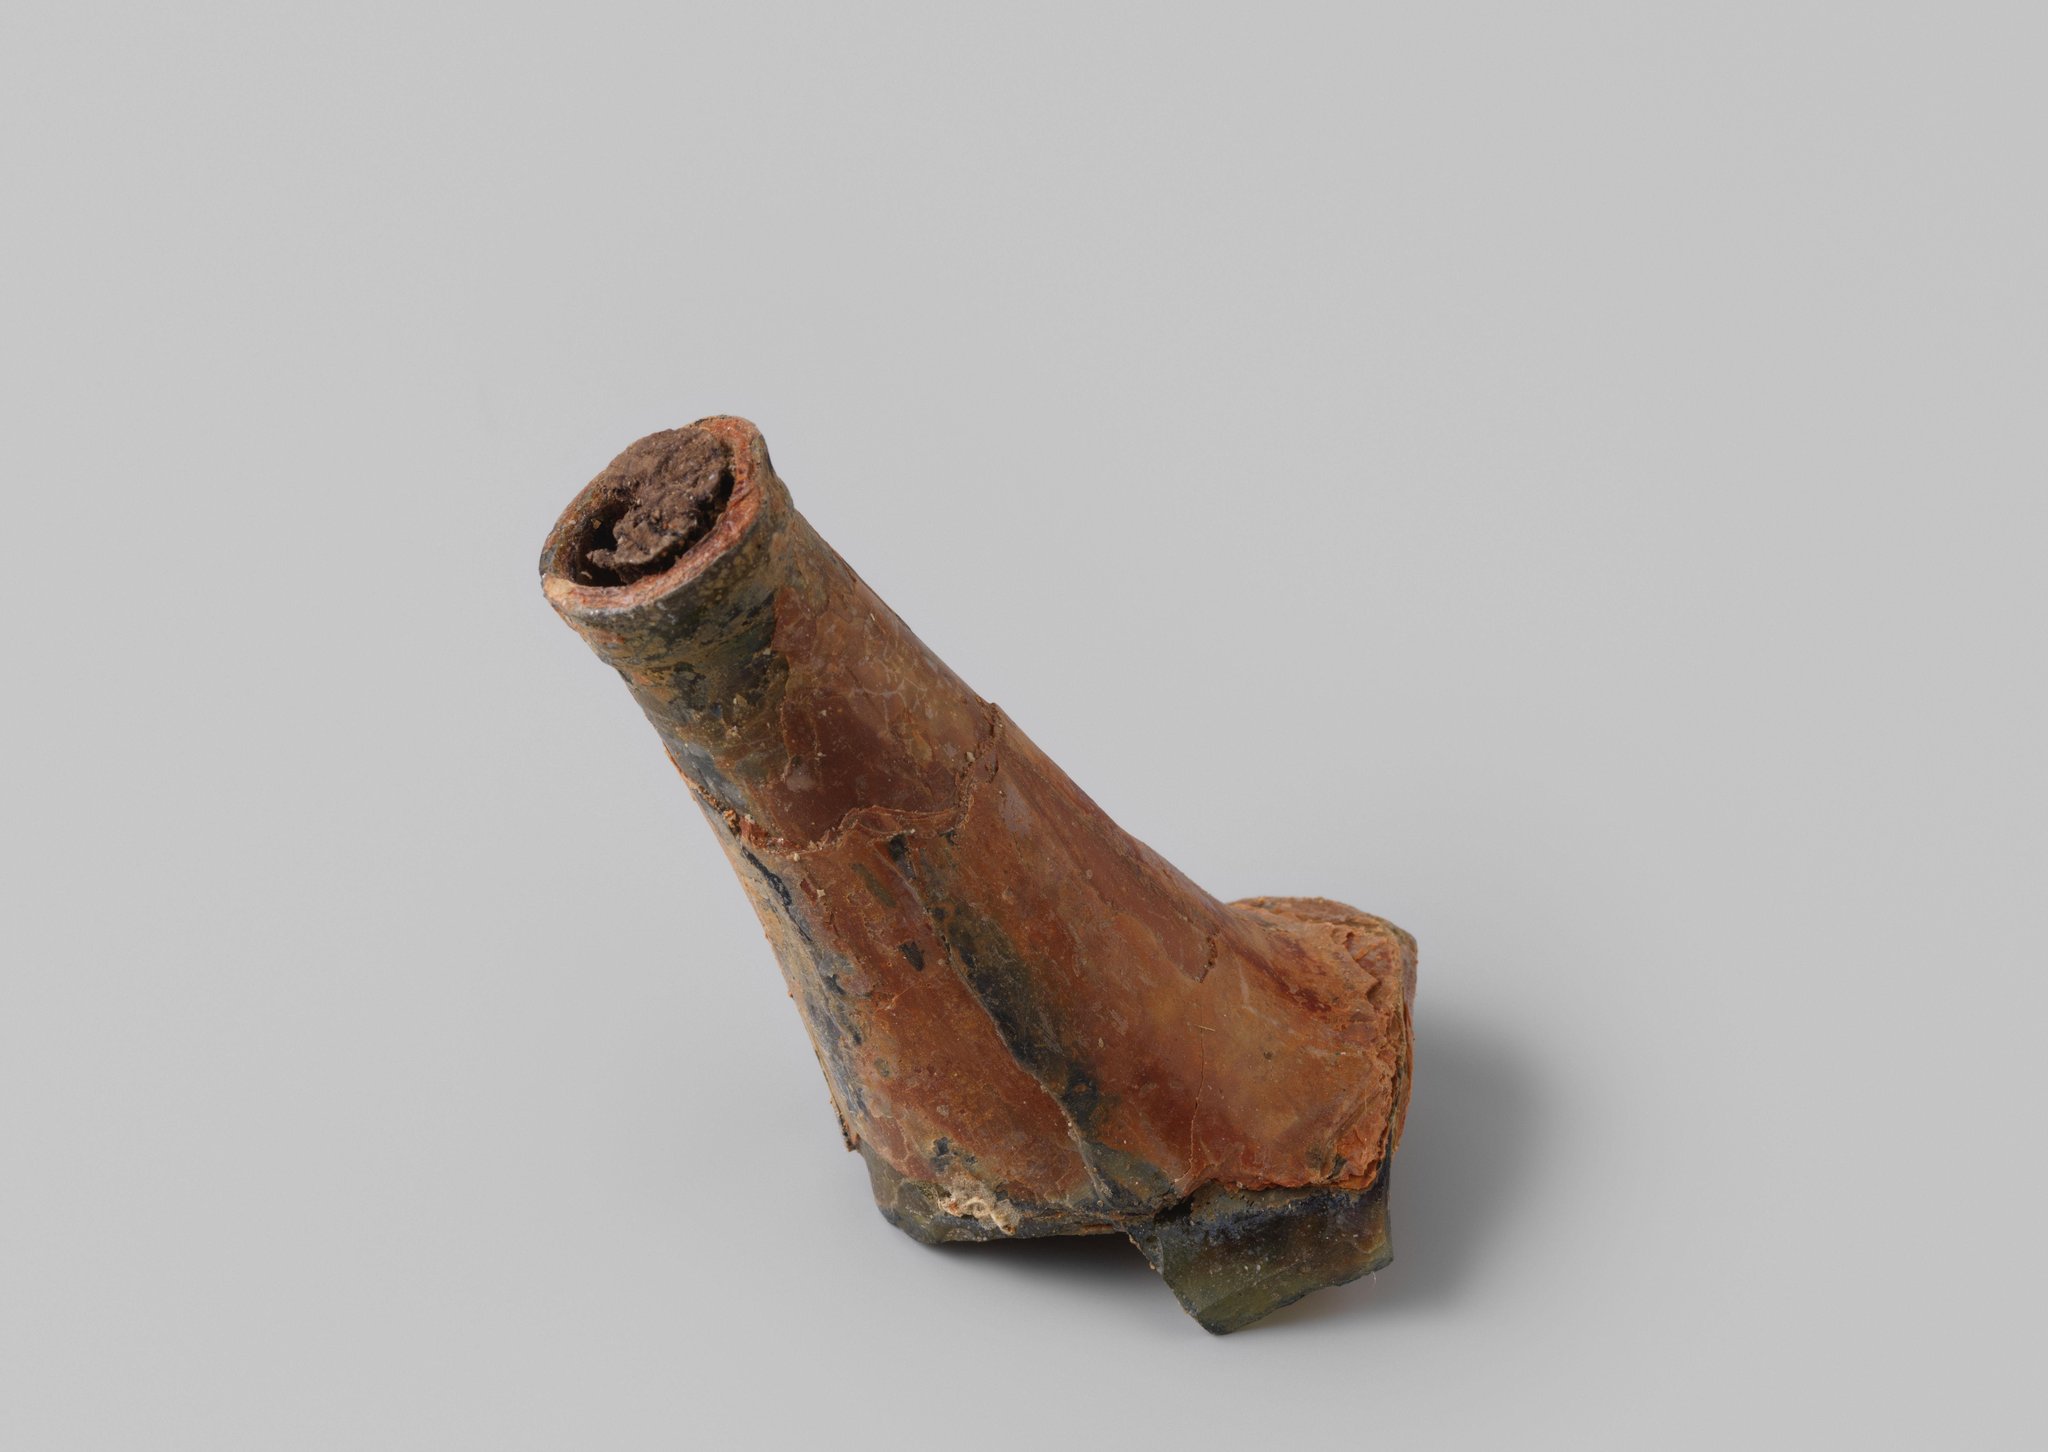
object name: wine bottle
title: Hals met kurk van een wijnfles uit het wrak van de Oost-Indiëvaarder Hollandia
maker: Anonymous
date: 1700-1743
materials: cork, glass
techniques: green glass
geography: netherlands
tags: verenigde oostindische compagnie, hollandia (schip), annet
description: Wine bottle, continental production, neck, onion-shaped bottle or bottle with vertical side; vs-string rim, cork level with mouth.